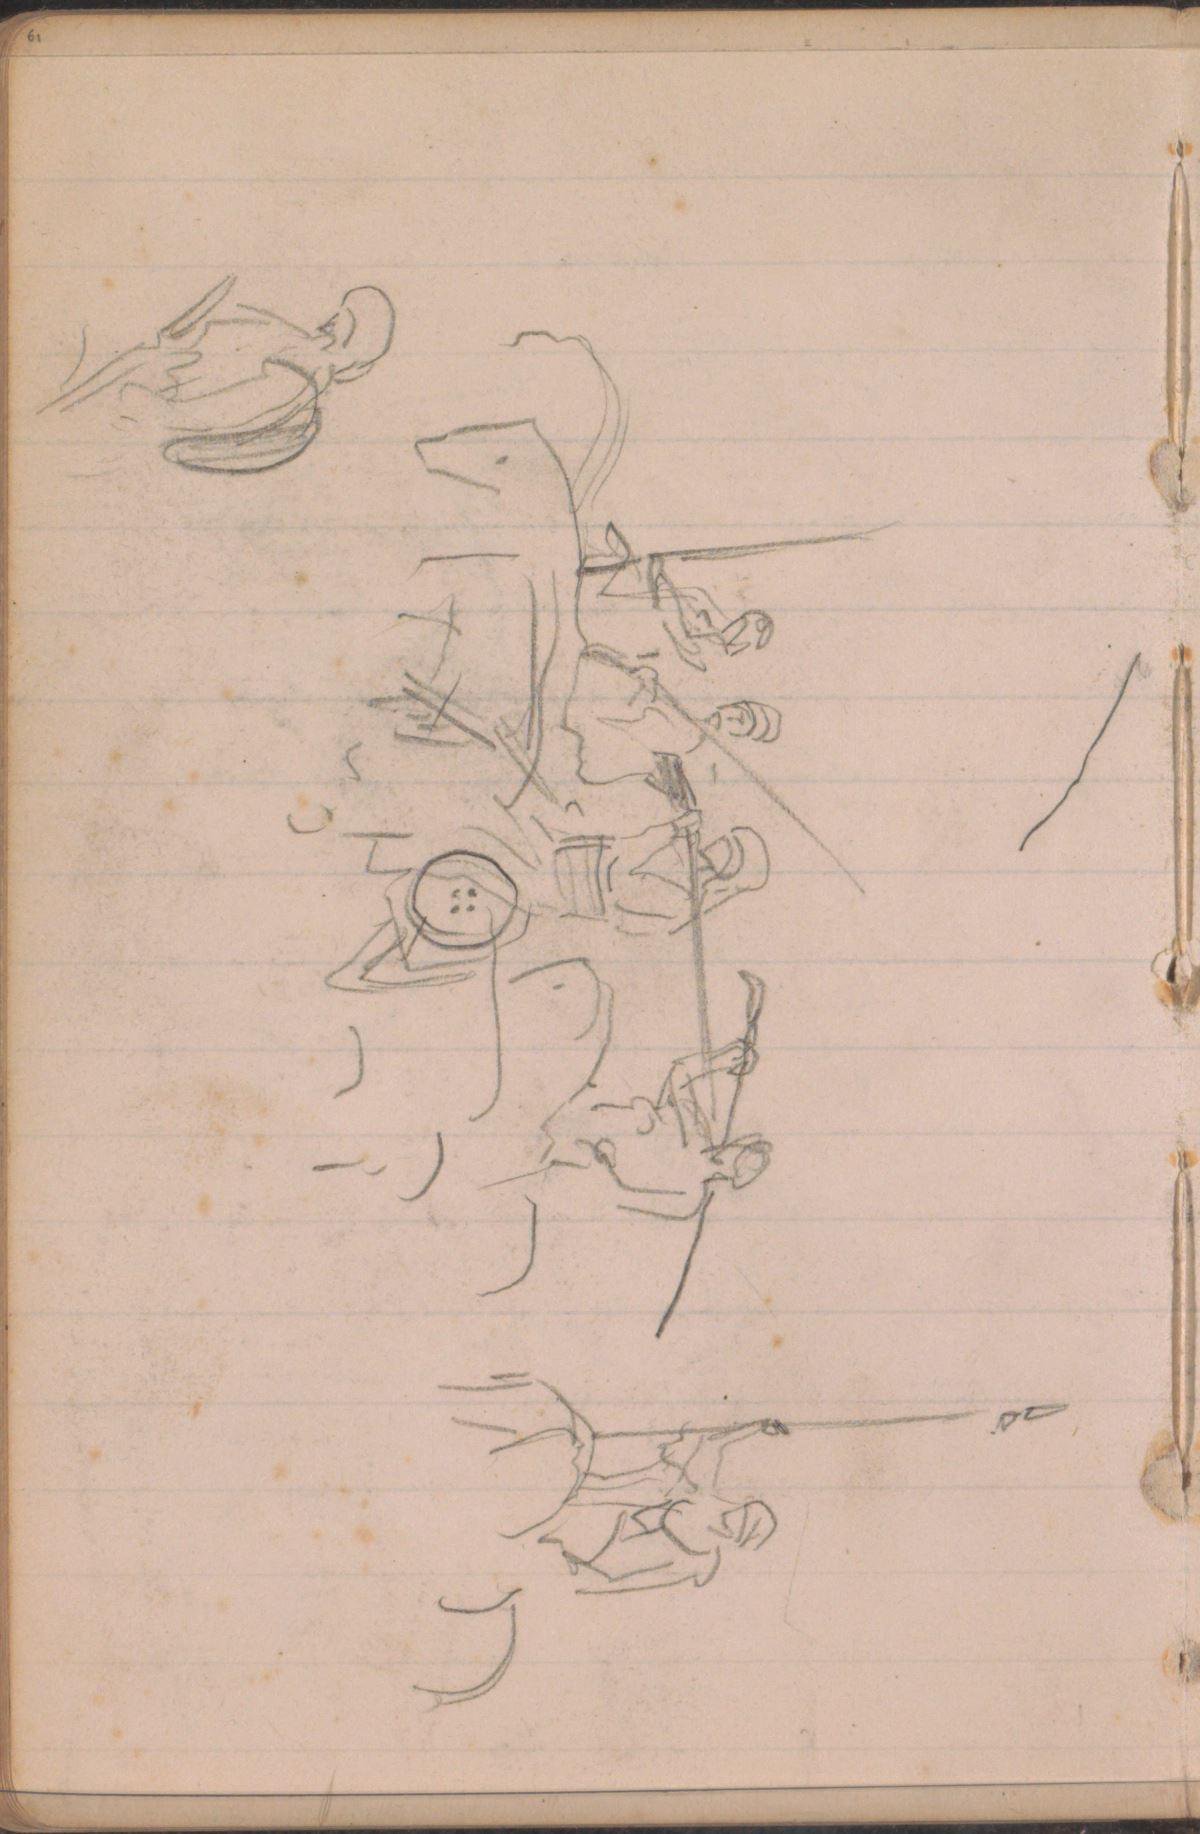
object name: sketchbook leaf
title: Indiërs op paarden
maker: marius bauer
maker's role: draughtsman, print maker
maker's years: 1867-1932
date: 1897-1898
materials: pencil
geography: india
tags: riding a horse, ass, or mule; rider, horseman, hacking and thrusting weapons: sword, asiatic races and peoples: indians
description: De figuren dragen zwaarden. Pagina 61 uit een schetsboek met 84 bladen.